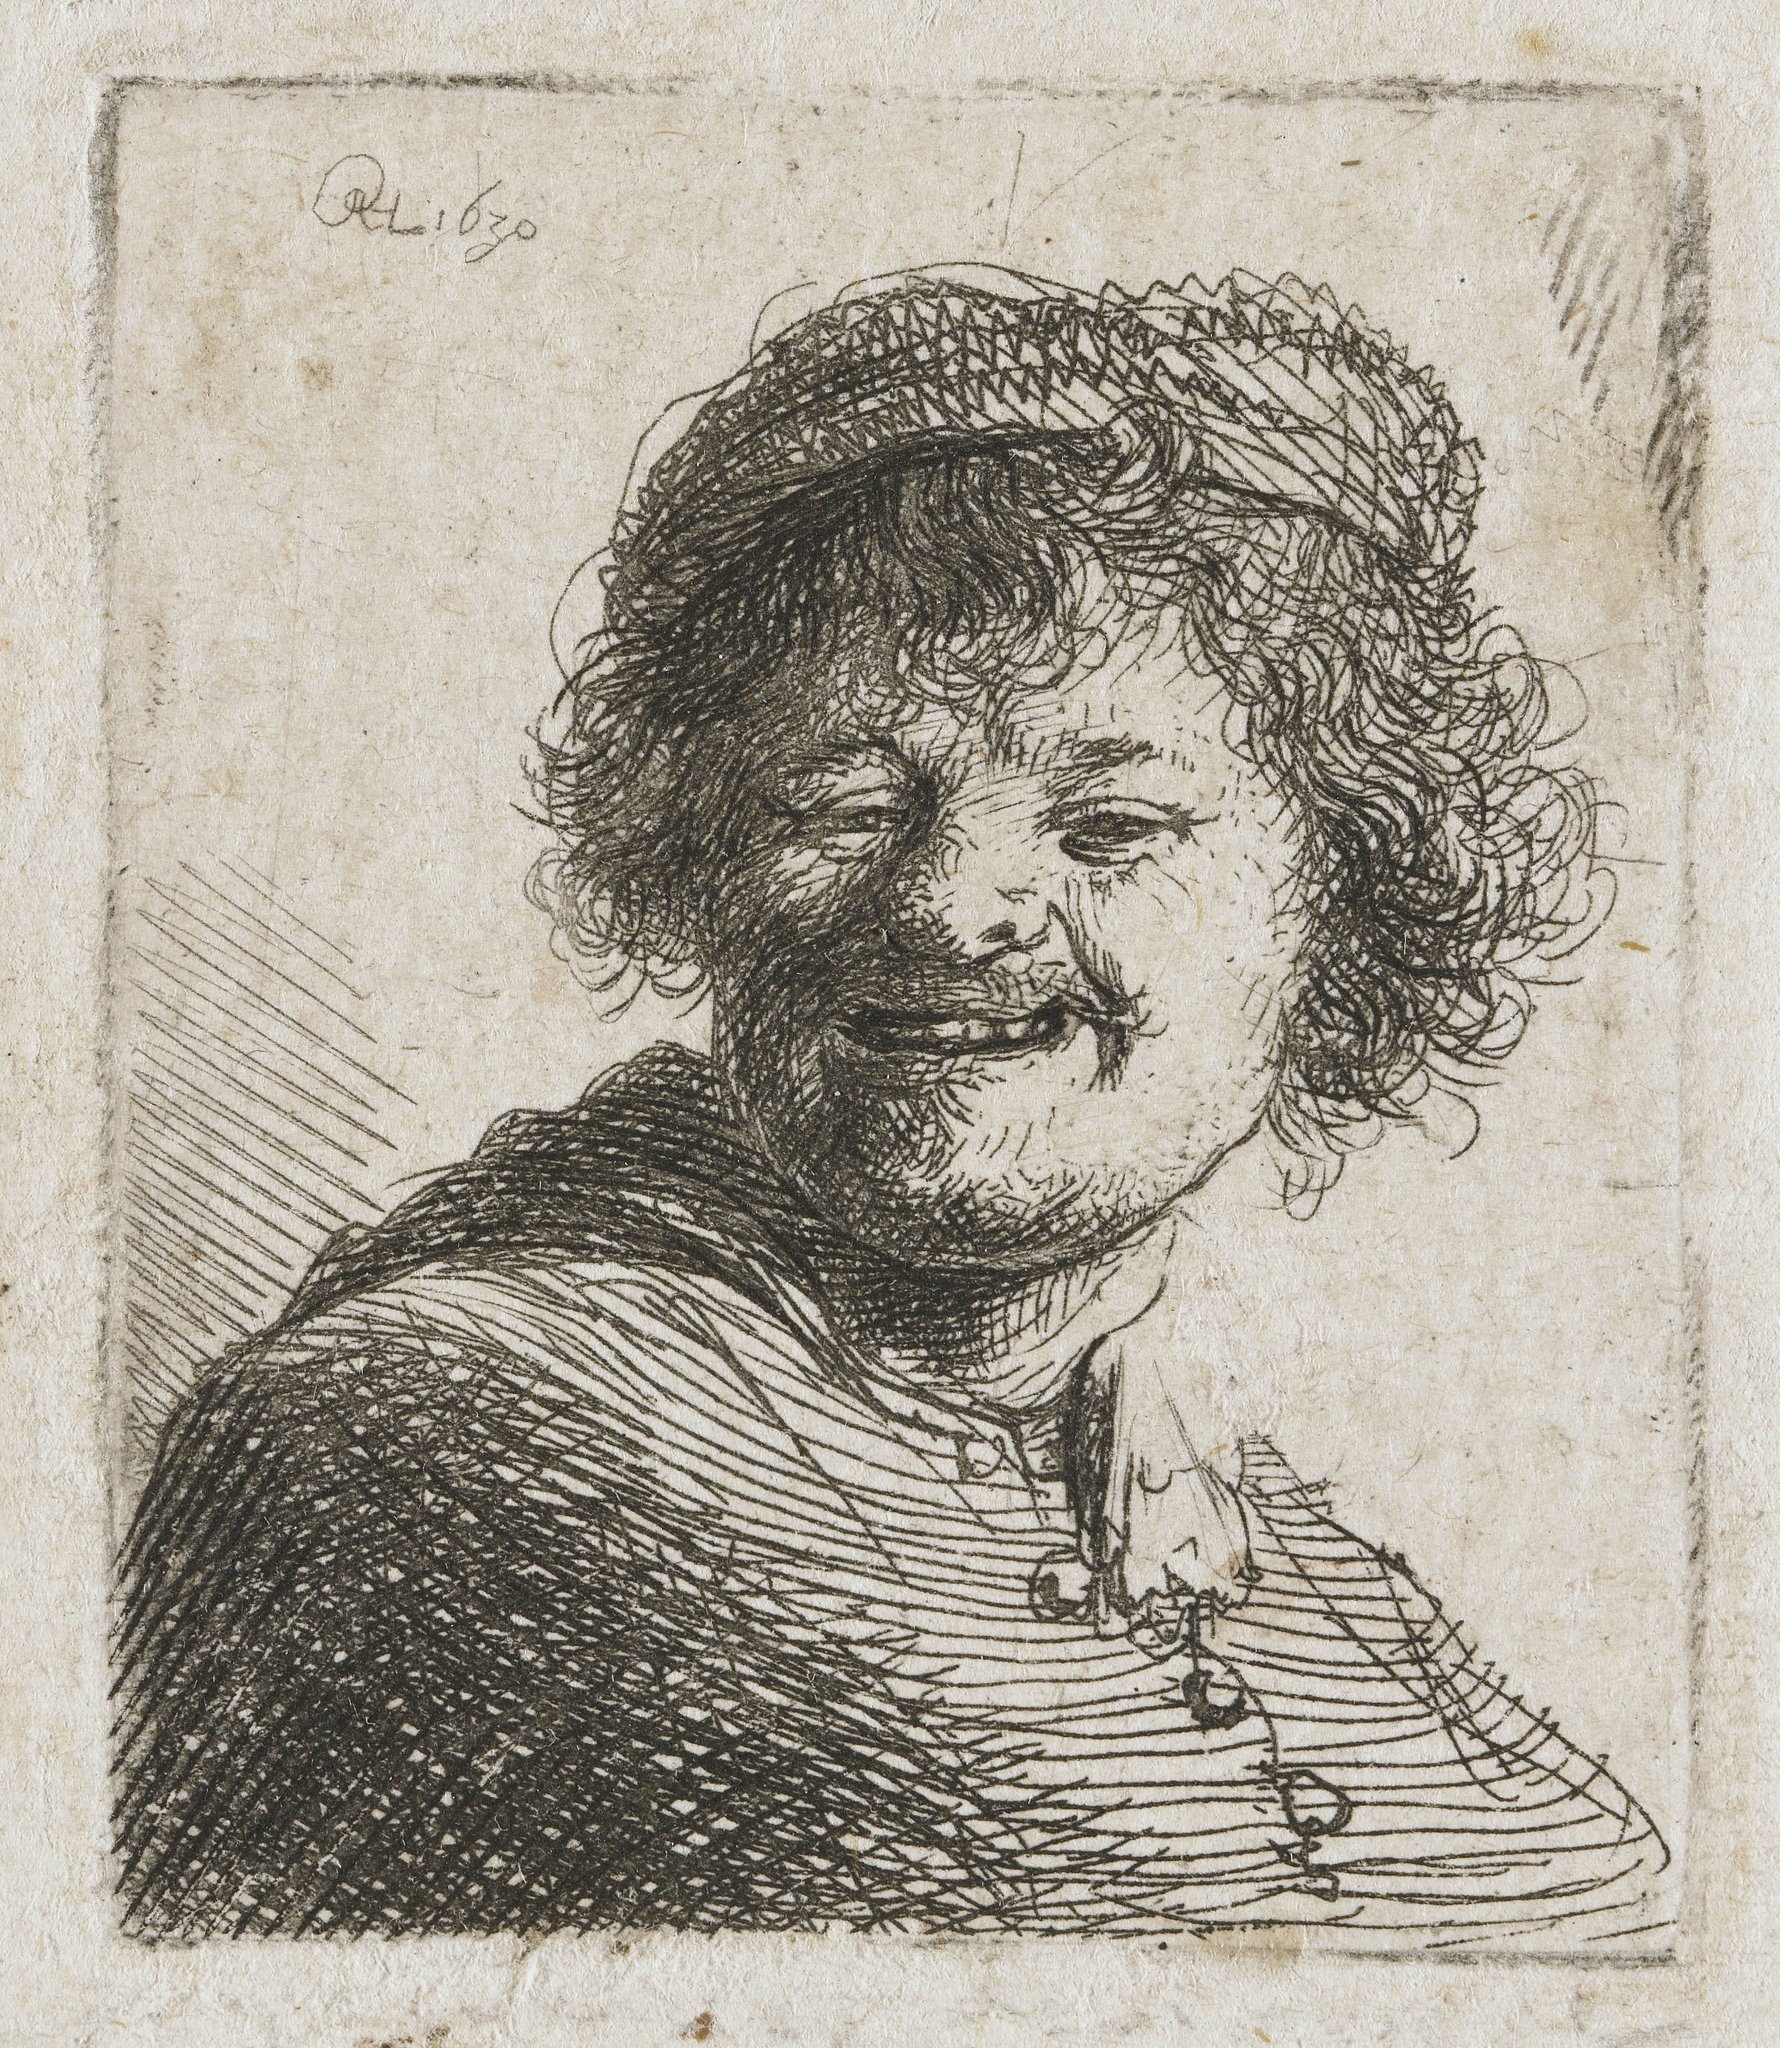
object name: print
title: Self-portrait in a cap: laughing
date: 1630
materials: paper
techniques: etching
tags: leiden, amsterdam, painter, print maker, draughtsman, rembrandt van rijn, head-gear: cap (+ men's clothes)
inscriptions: monogram and date: ‘RHL 1630’, collector's mark: Lugt 240